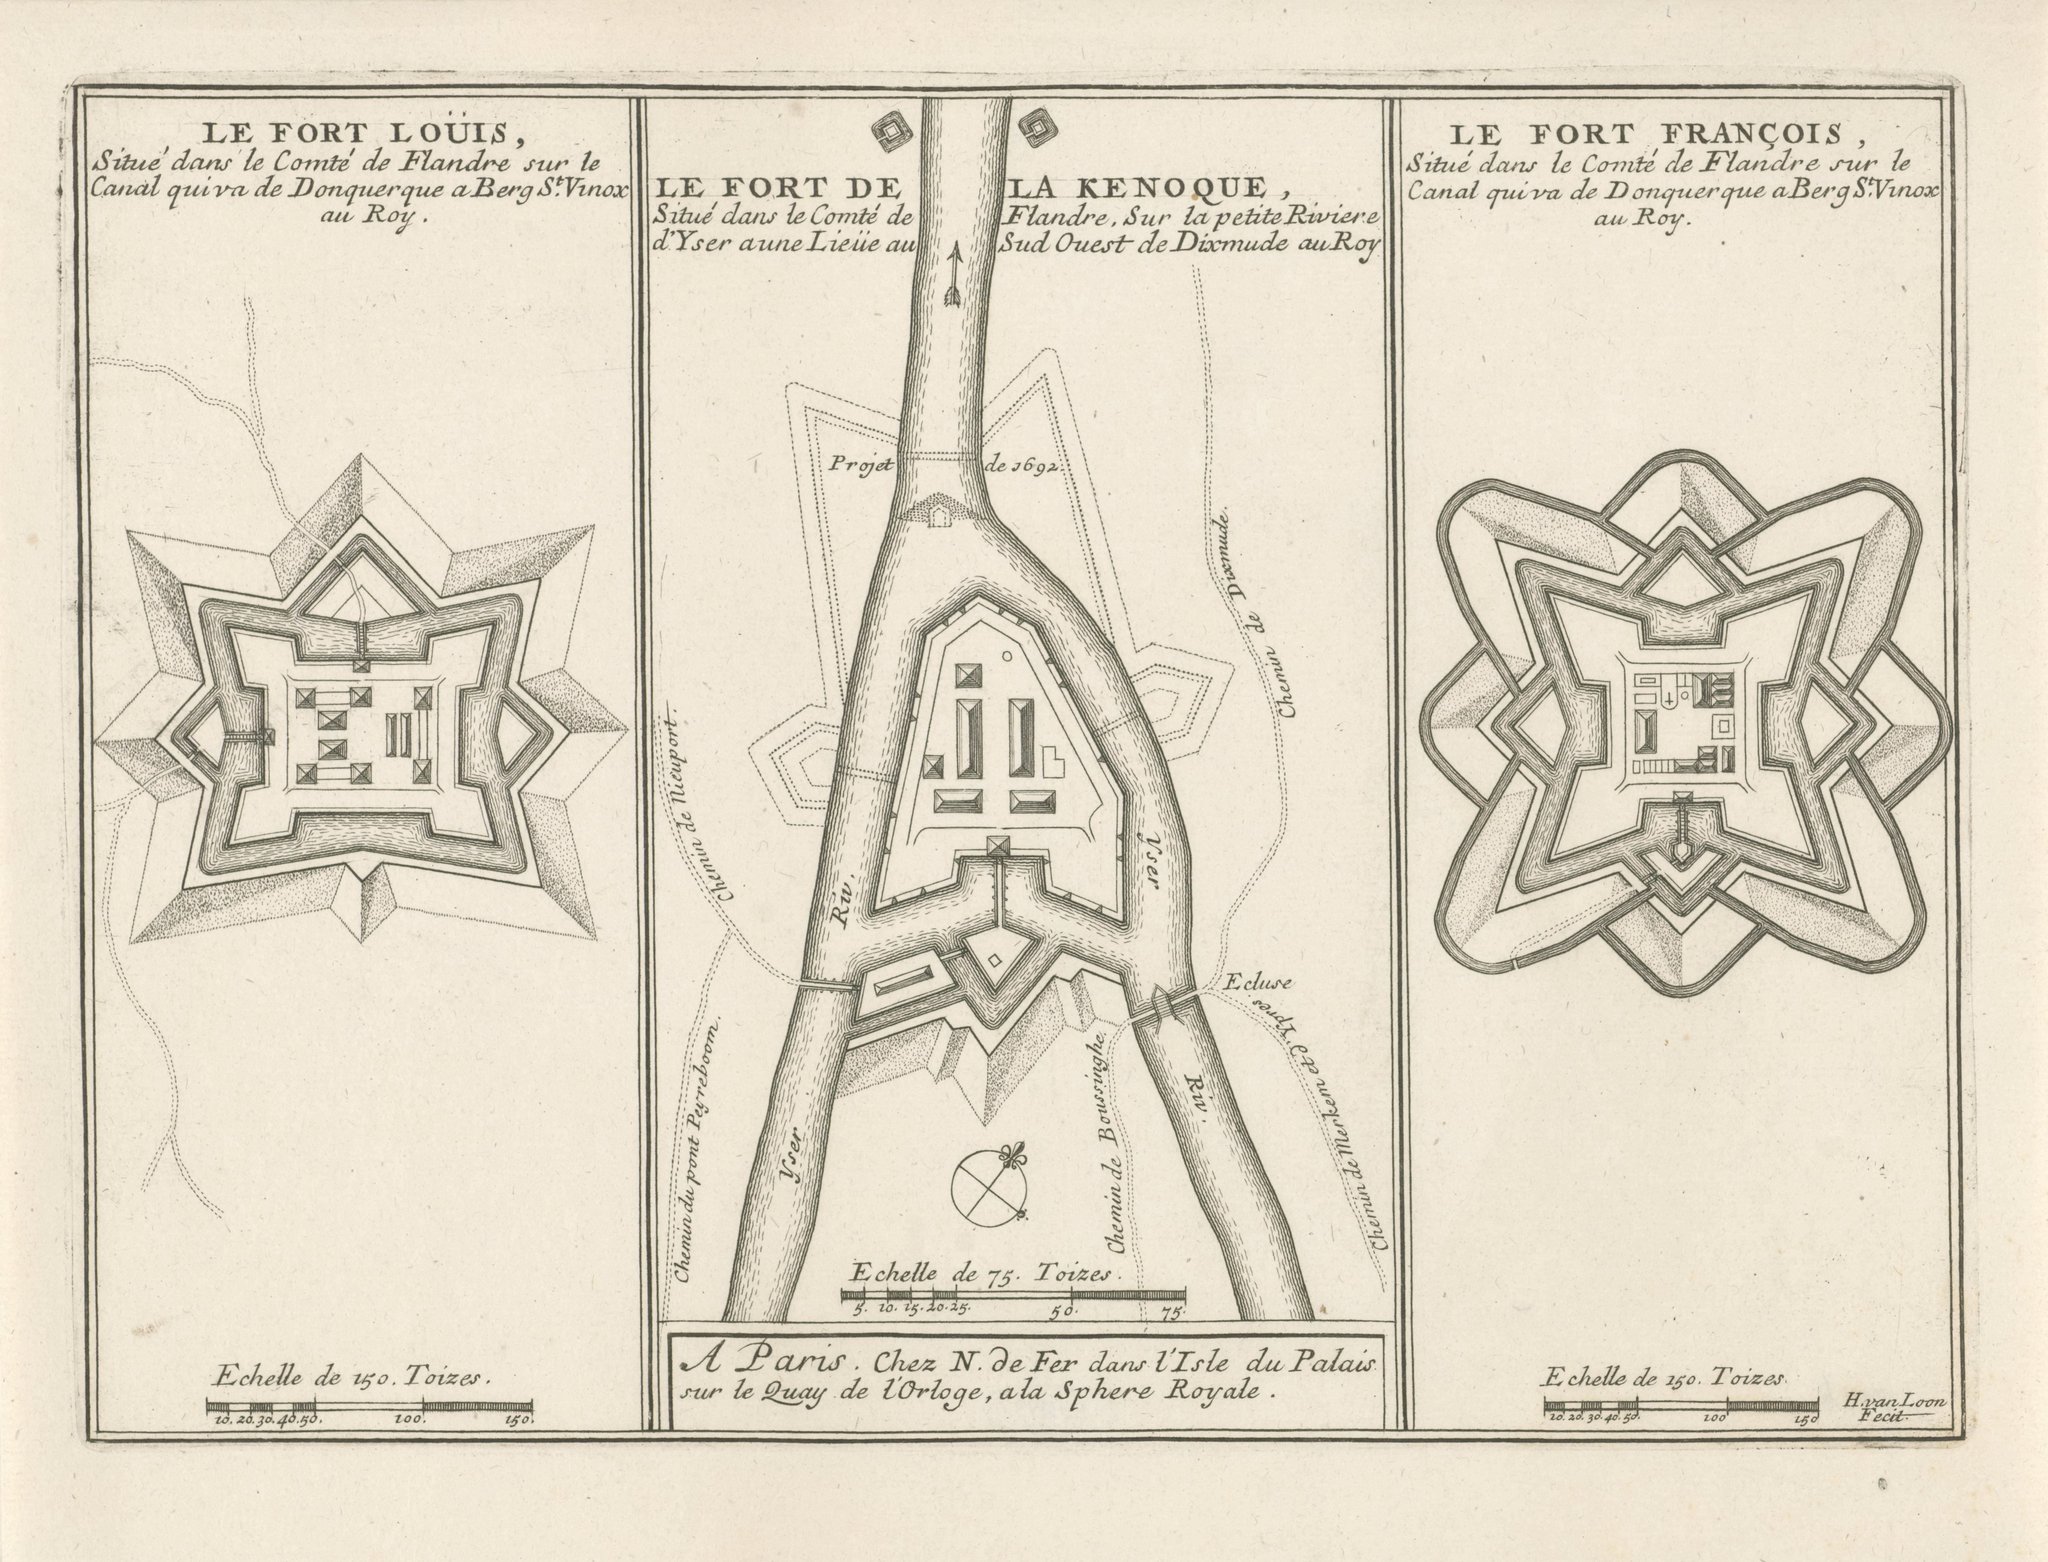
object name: print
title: Les forces de l'Europe, ou description des principales villes, avec leurs fortifications : dessignées par les meilleurs ingenieurs, particulierement celles (...) de la France, dont les plans ont esté levez par M. de Vauban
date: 1693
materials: paper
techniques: engraving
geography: paris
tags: fortress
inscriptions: collector's mark: Lugt 2228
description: De plattegronden van drie Franse forten in Vlaanderen. Onderdeel van het vijfde deel (1696) van het prentwerk waarin gebundeld zijn de acht delen van Les forces de l'Europe uitgegeven tussen 1693-1697. Het prentwerk bestaat uit 175 platen met plannen (afkomstig van Sébastien Le Prestre, Seigneur de Vauban) van vermaarde sterke steden en vestingen in de Negenjarige Oorlog. Titel en opschriften in het Frans.